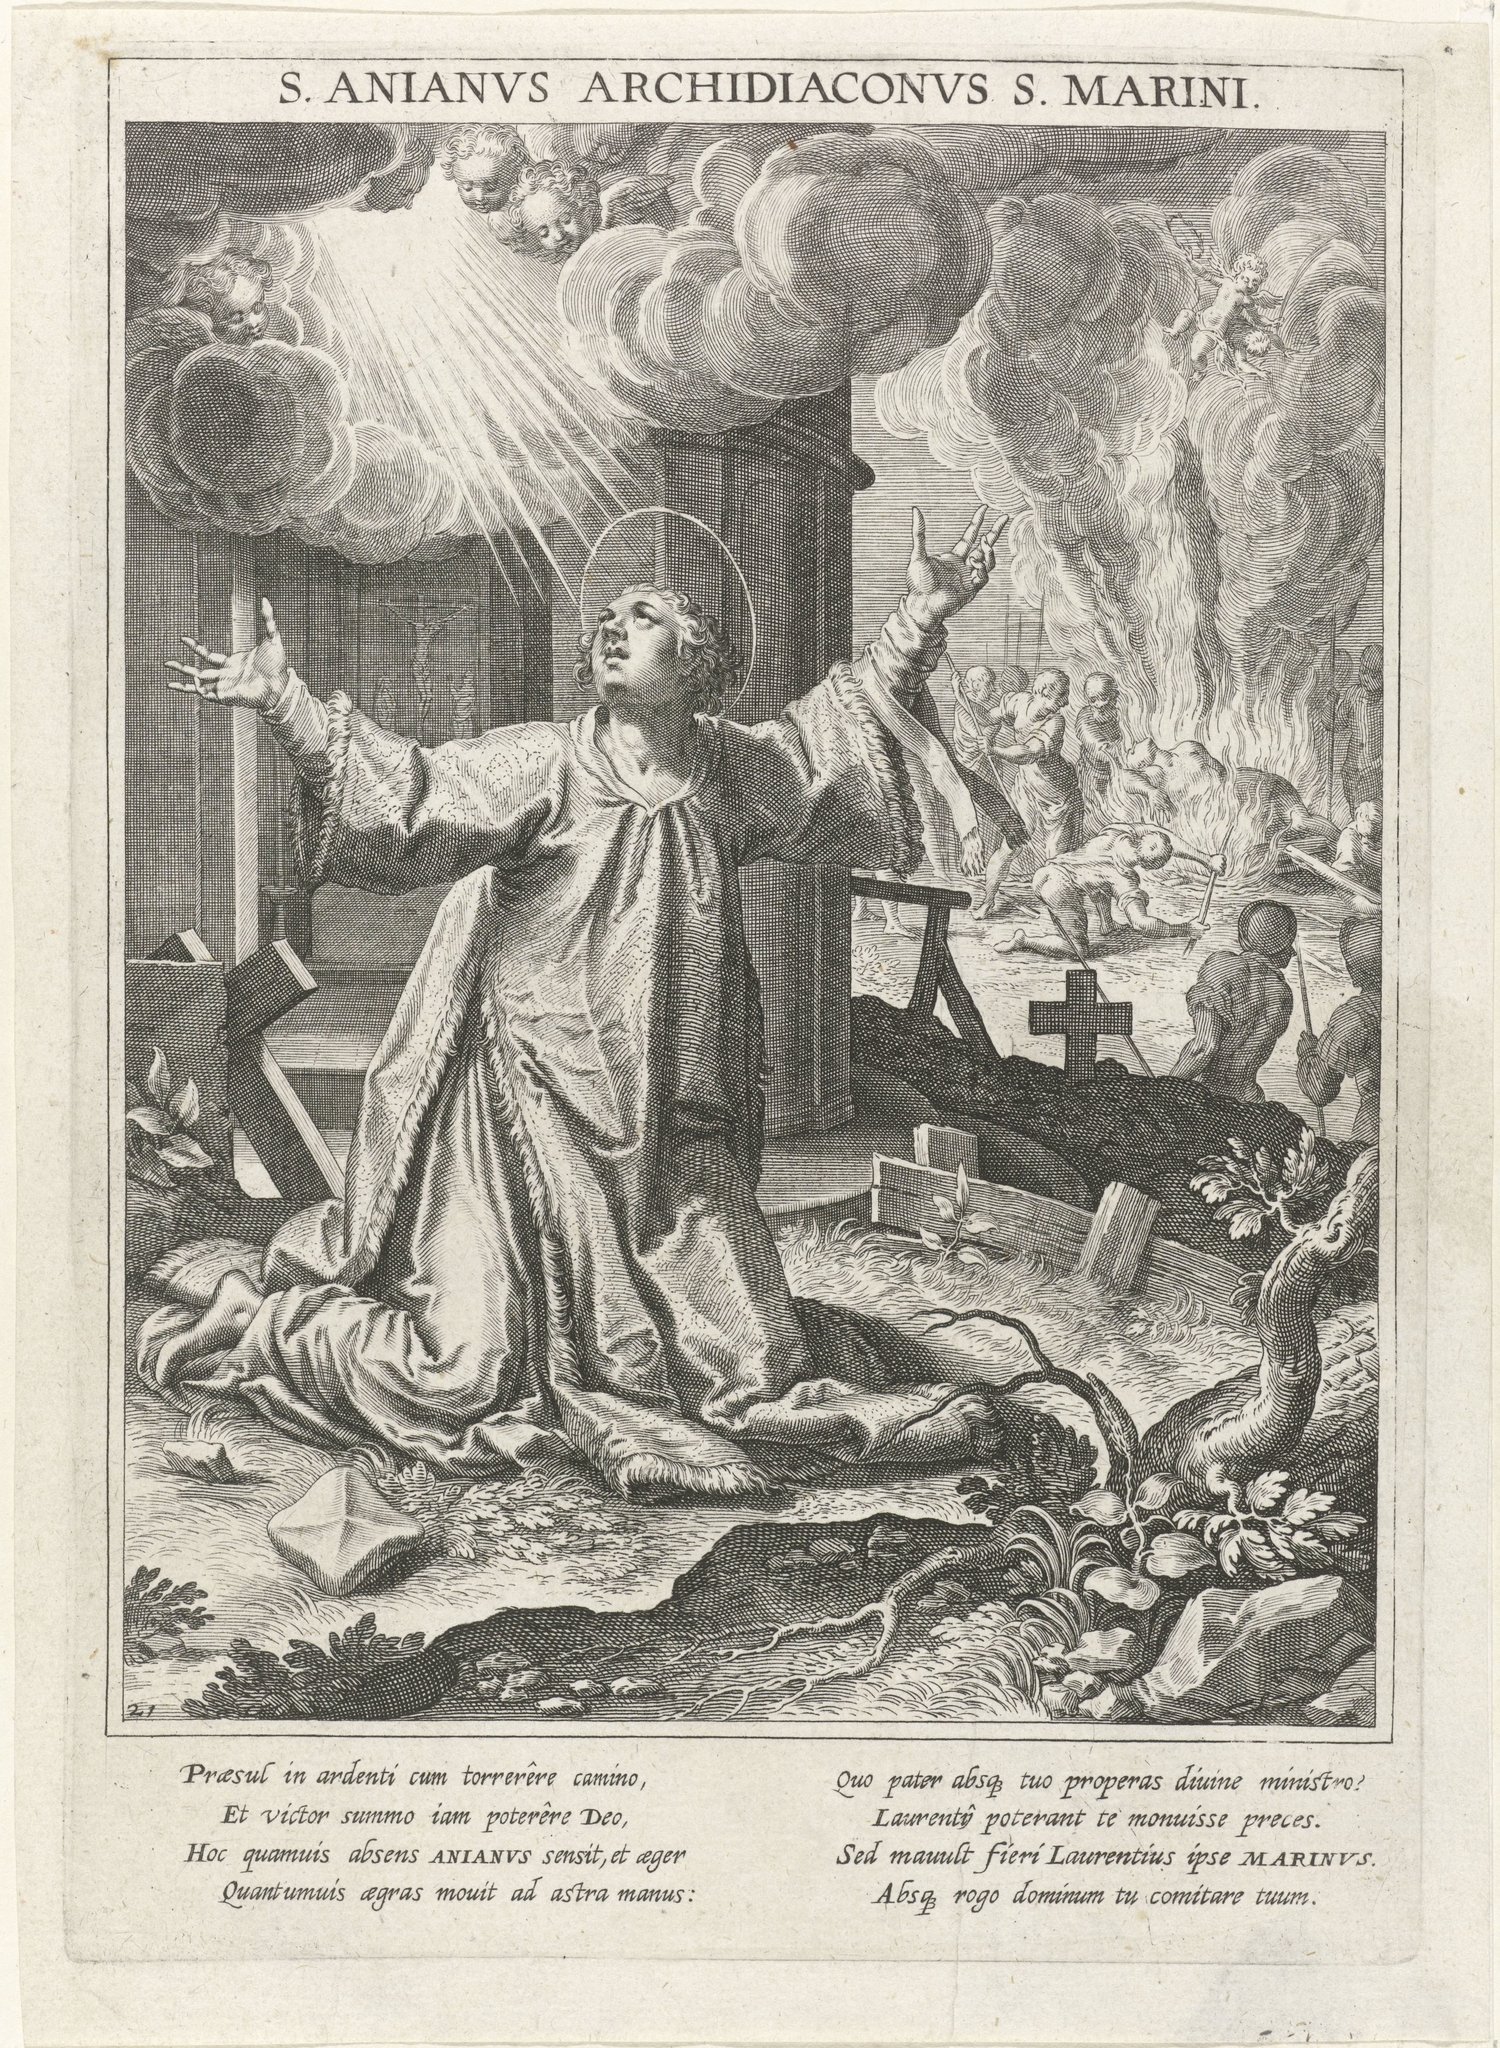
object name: print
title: Bavaria sancta I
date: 1615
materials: paper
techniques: engraving, etching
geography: munich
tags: male saints (with name), appeal, angels crowning and/or bringing palm-branches, violent death ~ fire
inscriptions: collector's mark: Lugt 240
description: De H. Anianus, de vriend van H. Marianus, smeekt God om de dood. Vanuit de hemel vallen lichtstralen op hem neer. Op de achtergrond wordt de H. Marianus van Beieren door de stam der Vandalen op een brandstapel gegooid. Twee engelen dalen uit de hemel af om zijn ziel op te nemen. De prent heeft een Latijns onderschrift en is de eenentwintigste prent van een 60-delige serie met als onderwerp de heiligen van Beieren.